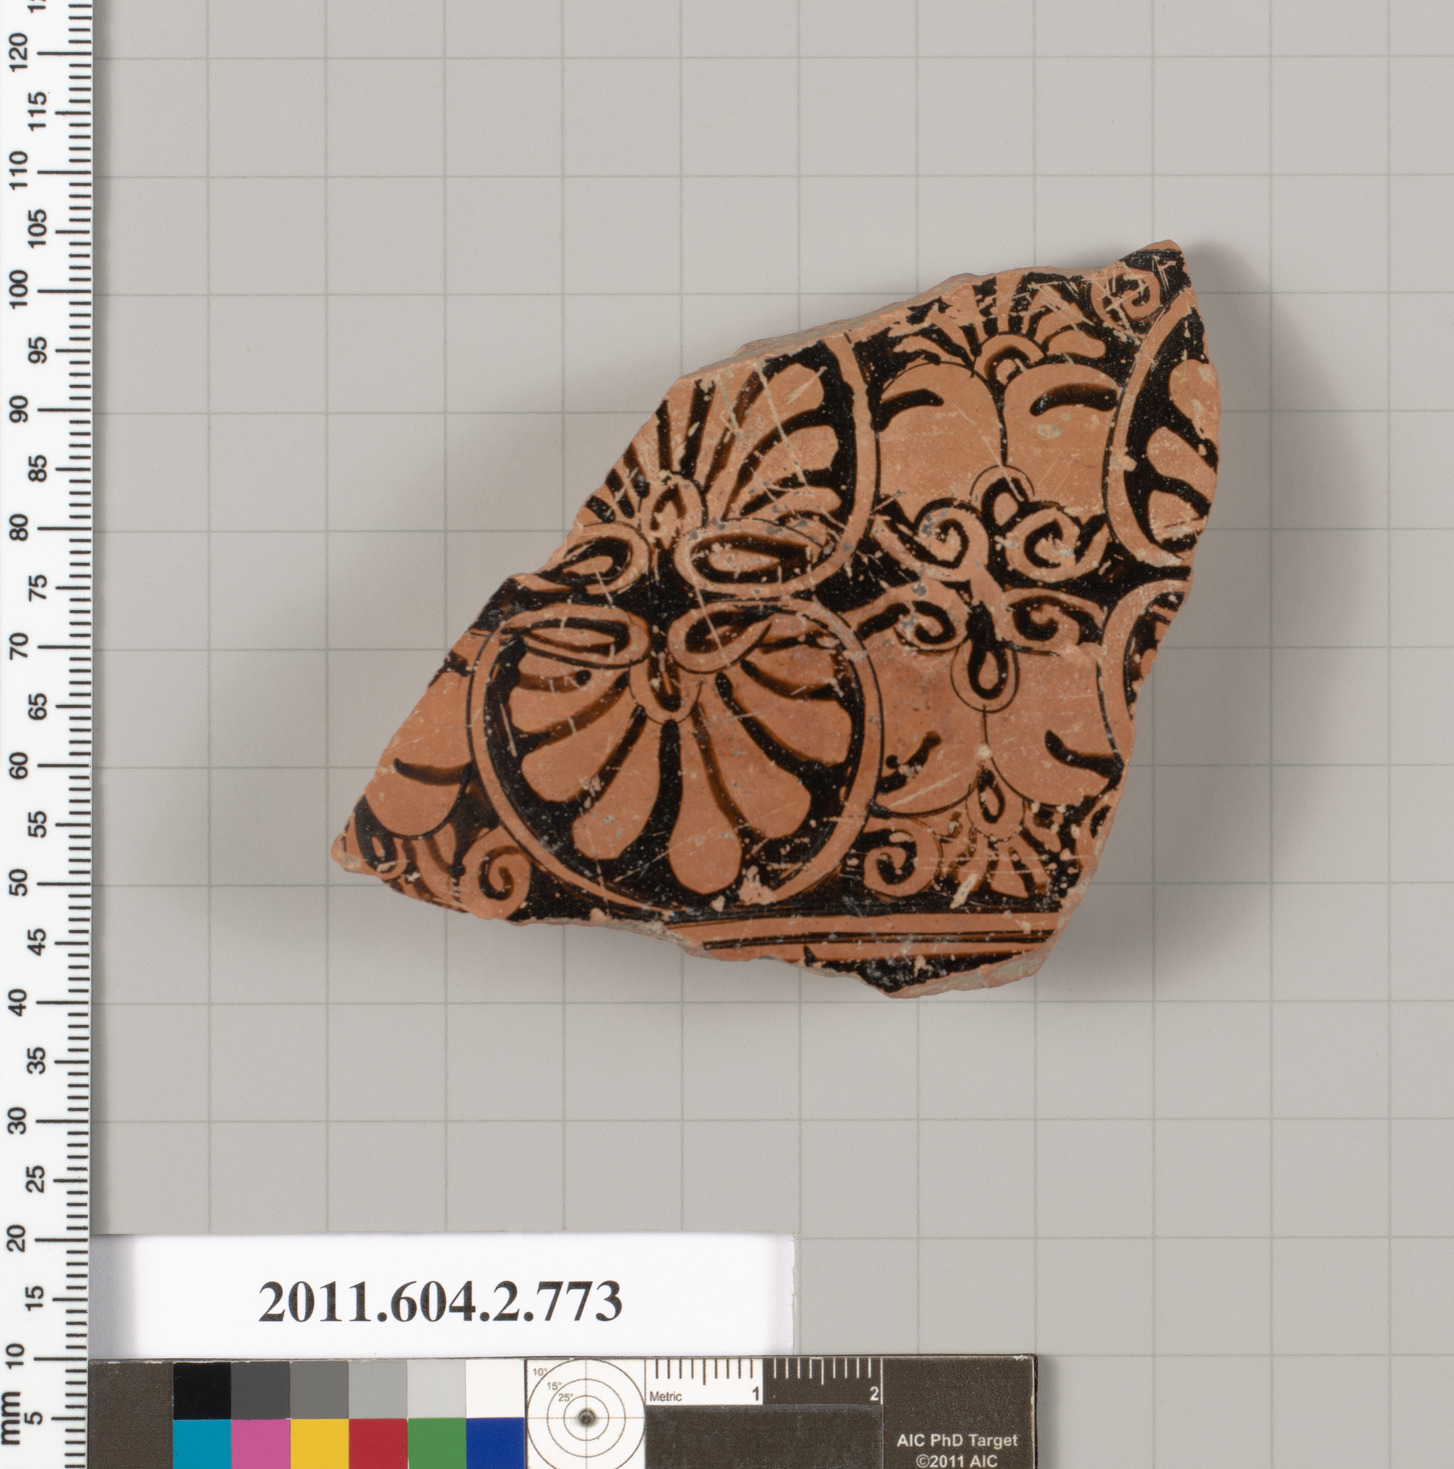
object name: calyx krater fragment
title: Terracotta fragment of a calyx-krater (bowl for mixing wine and water)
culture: greek, attic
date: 475-451 BCE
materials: terracotta